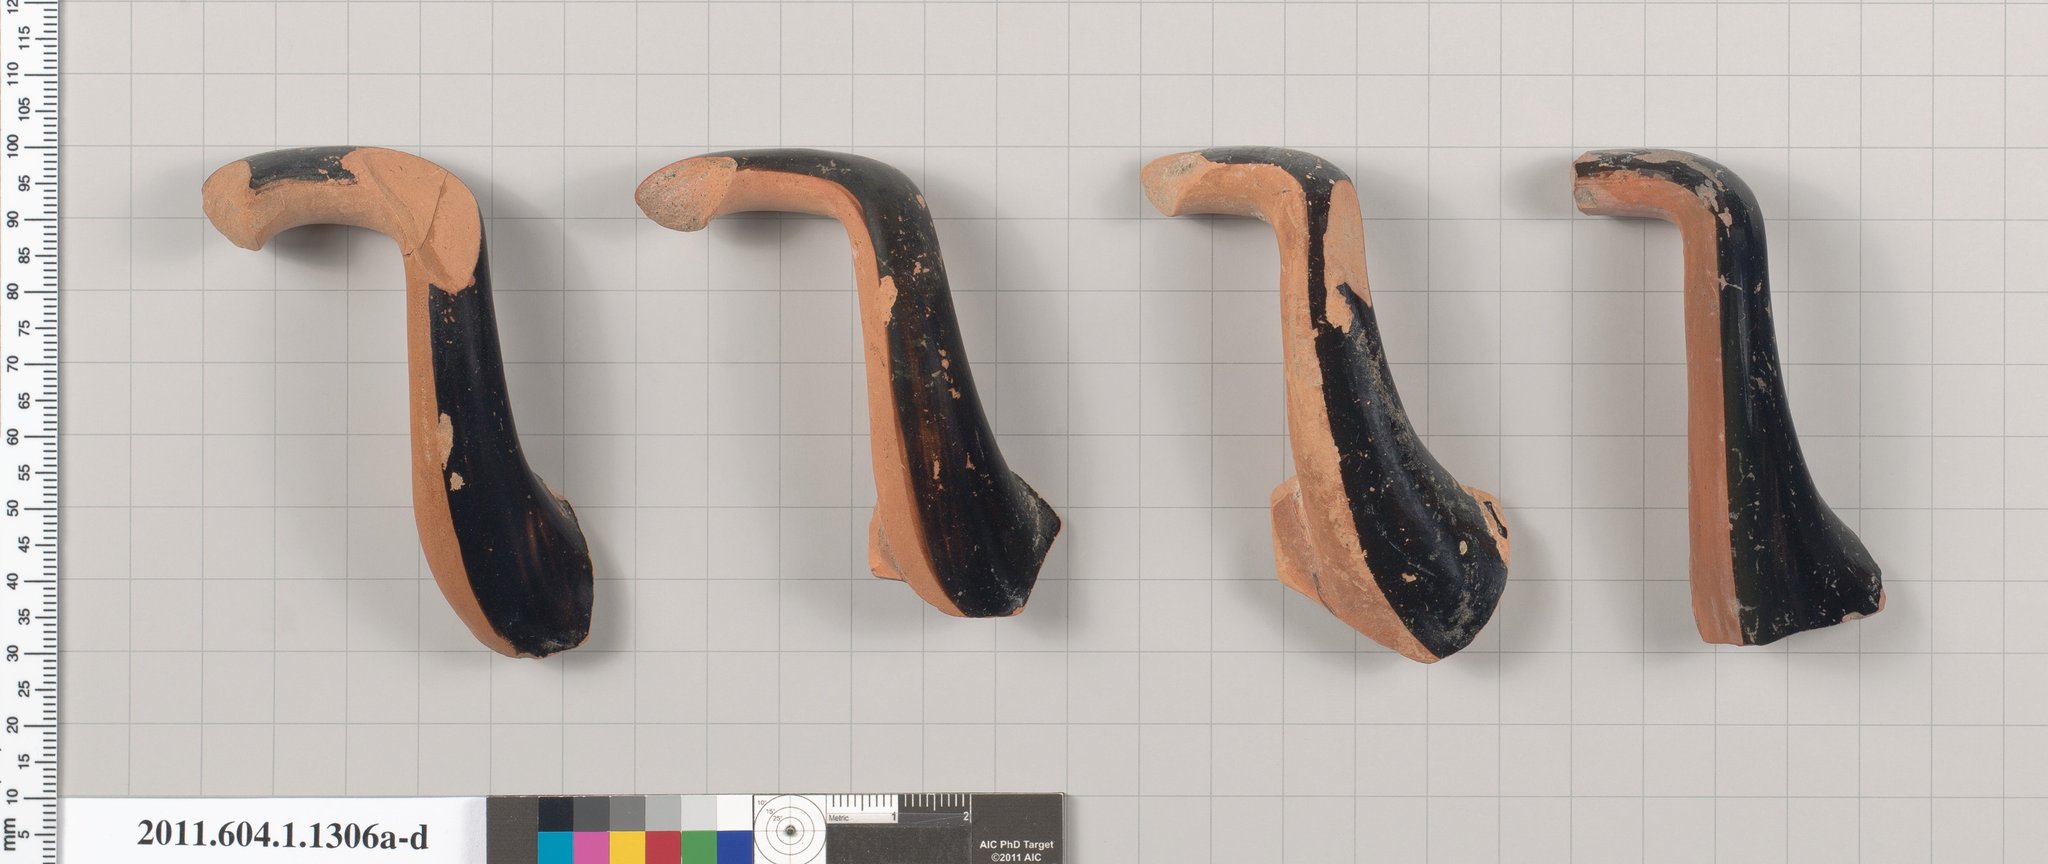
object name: kylix fragment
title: Terracotta fragments of kylikes (drinking cups)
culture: greek, attic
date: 500-401 BCE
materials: terracotta